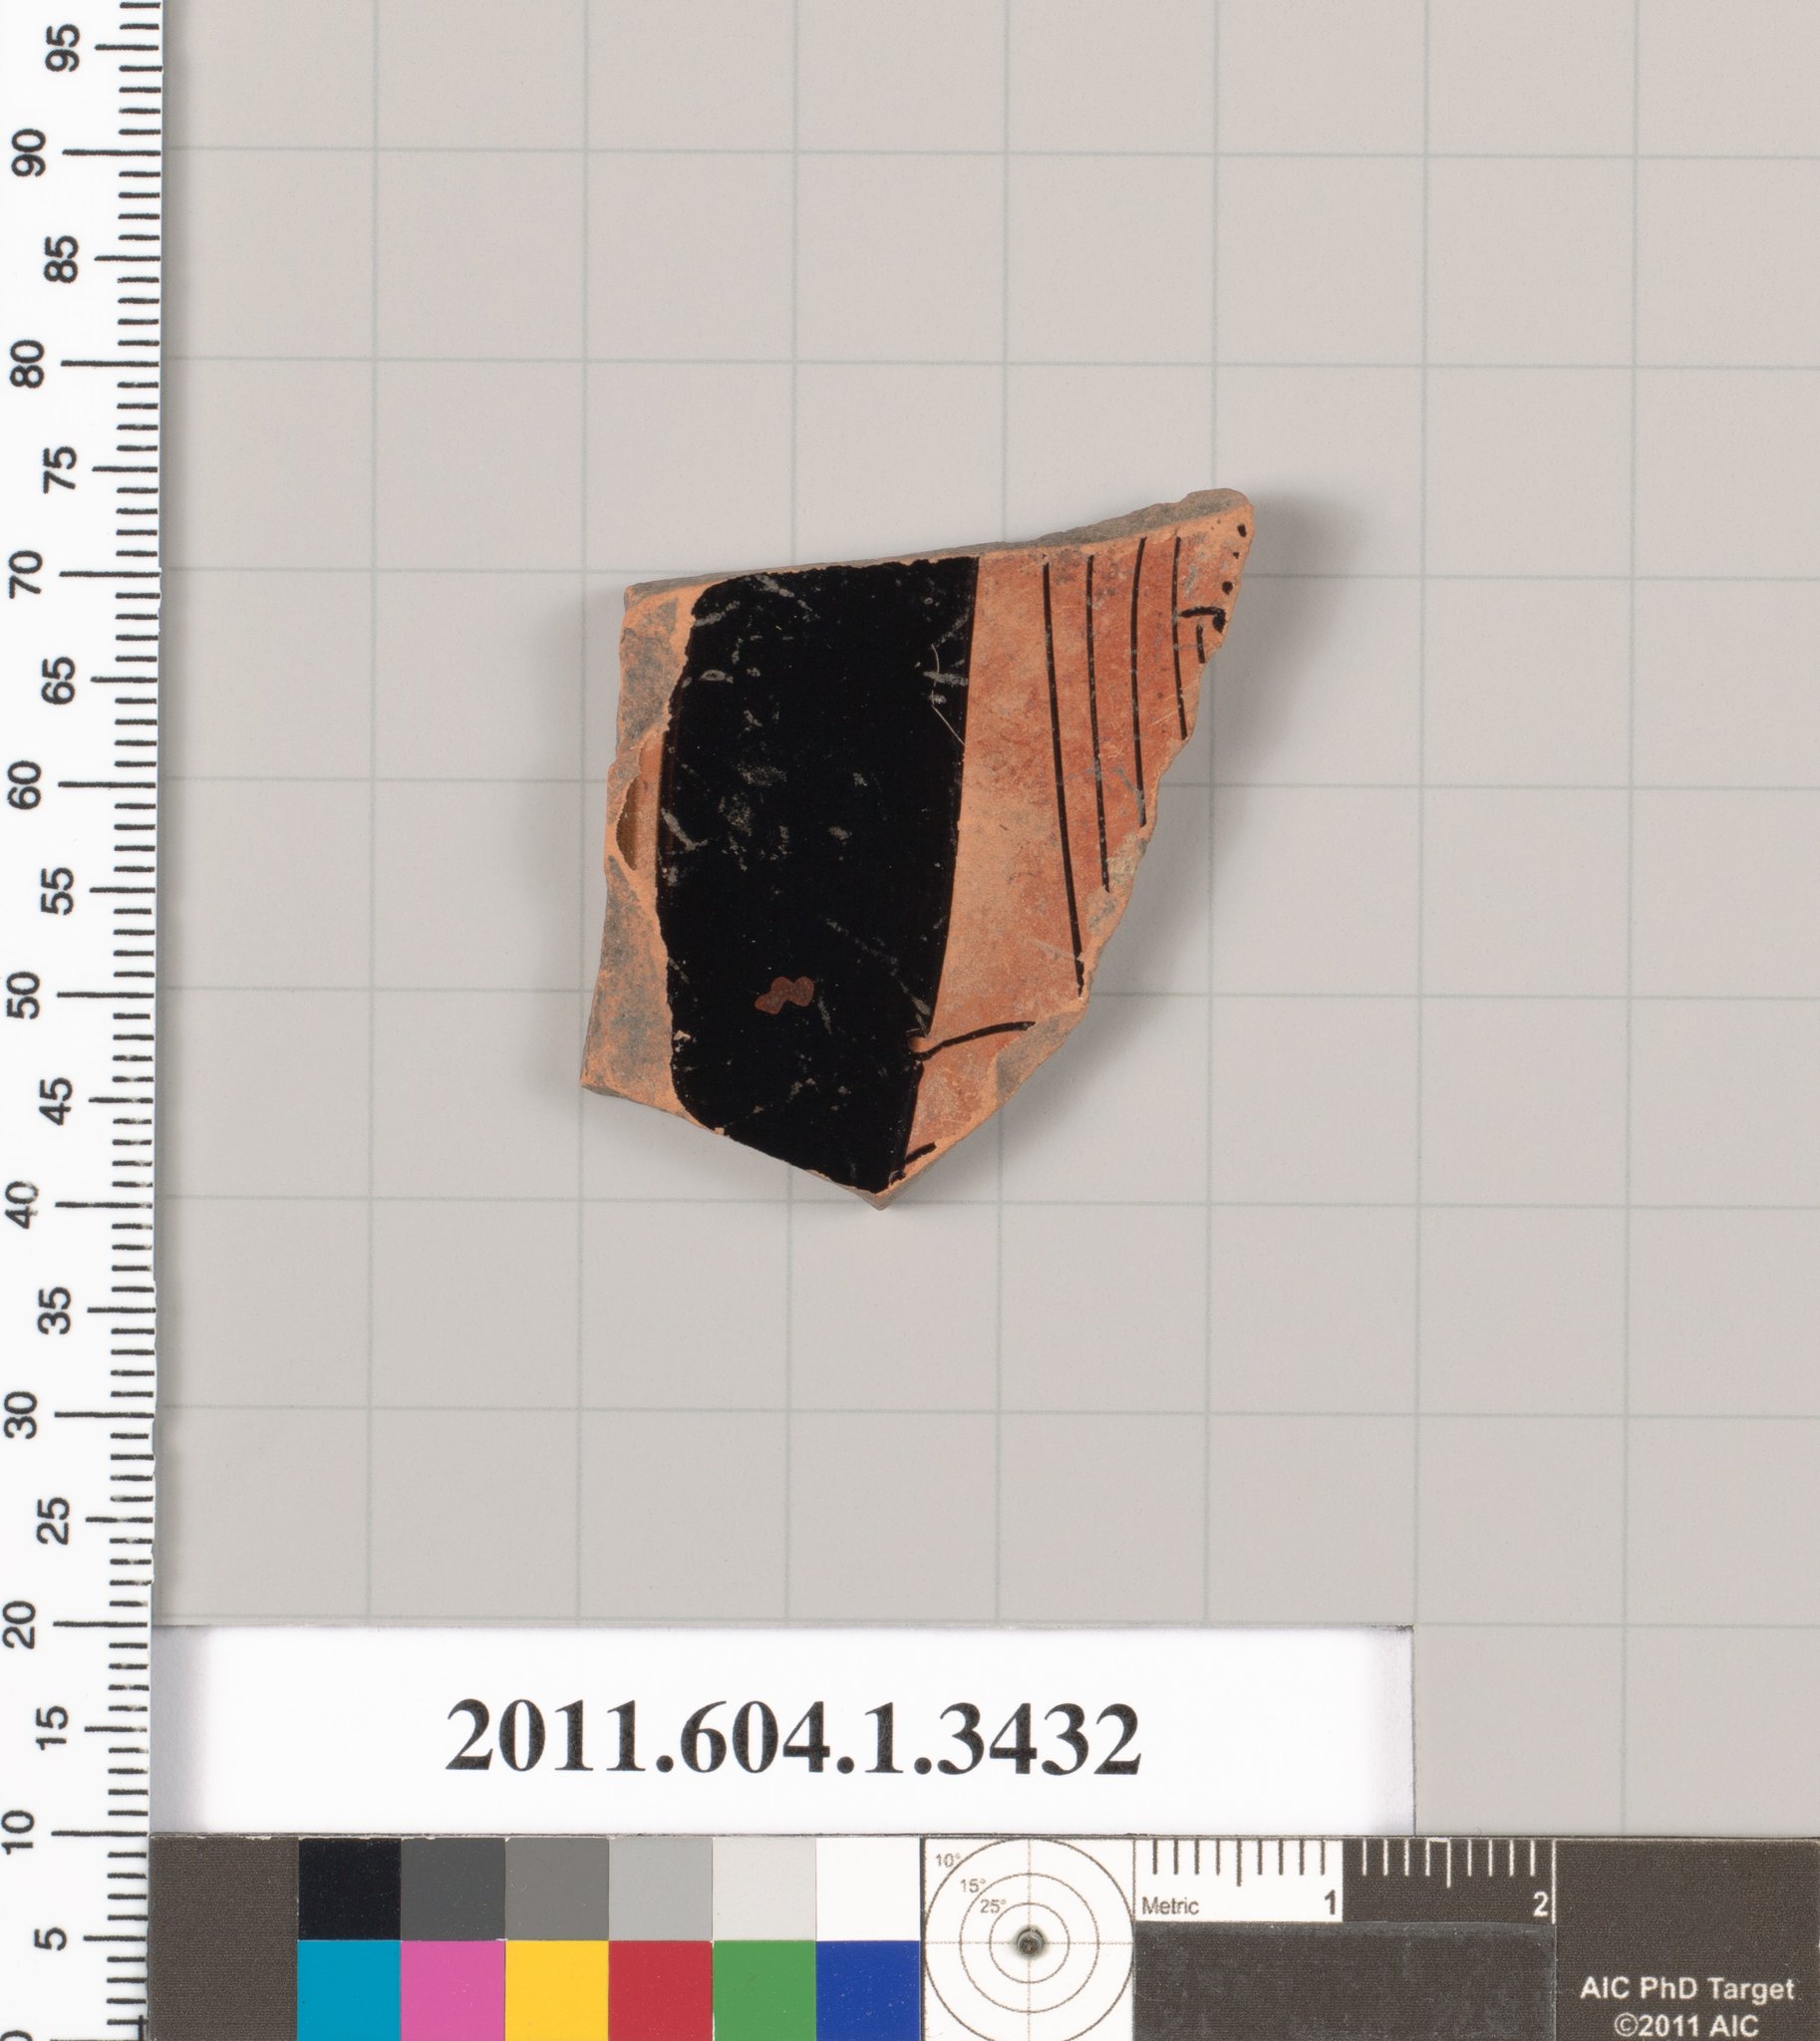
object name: kylix fragment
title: Terracotta fragment of a kylix (drinking cup)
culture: greek, attic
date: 500-476 BCE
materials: terracotta